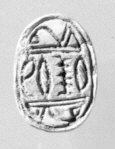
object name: stamp seal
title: Scarab seal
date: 1700-1560 BCE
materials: stone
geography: levant